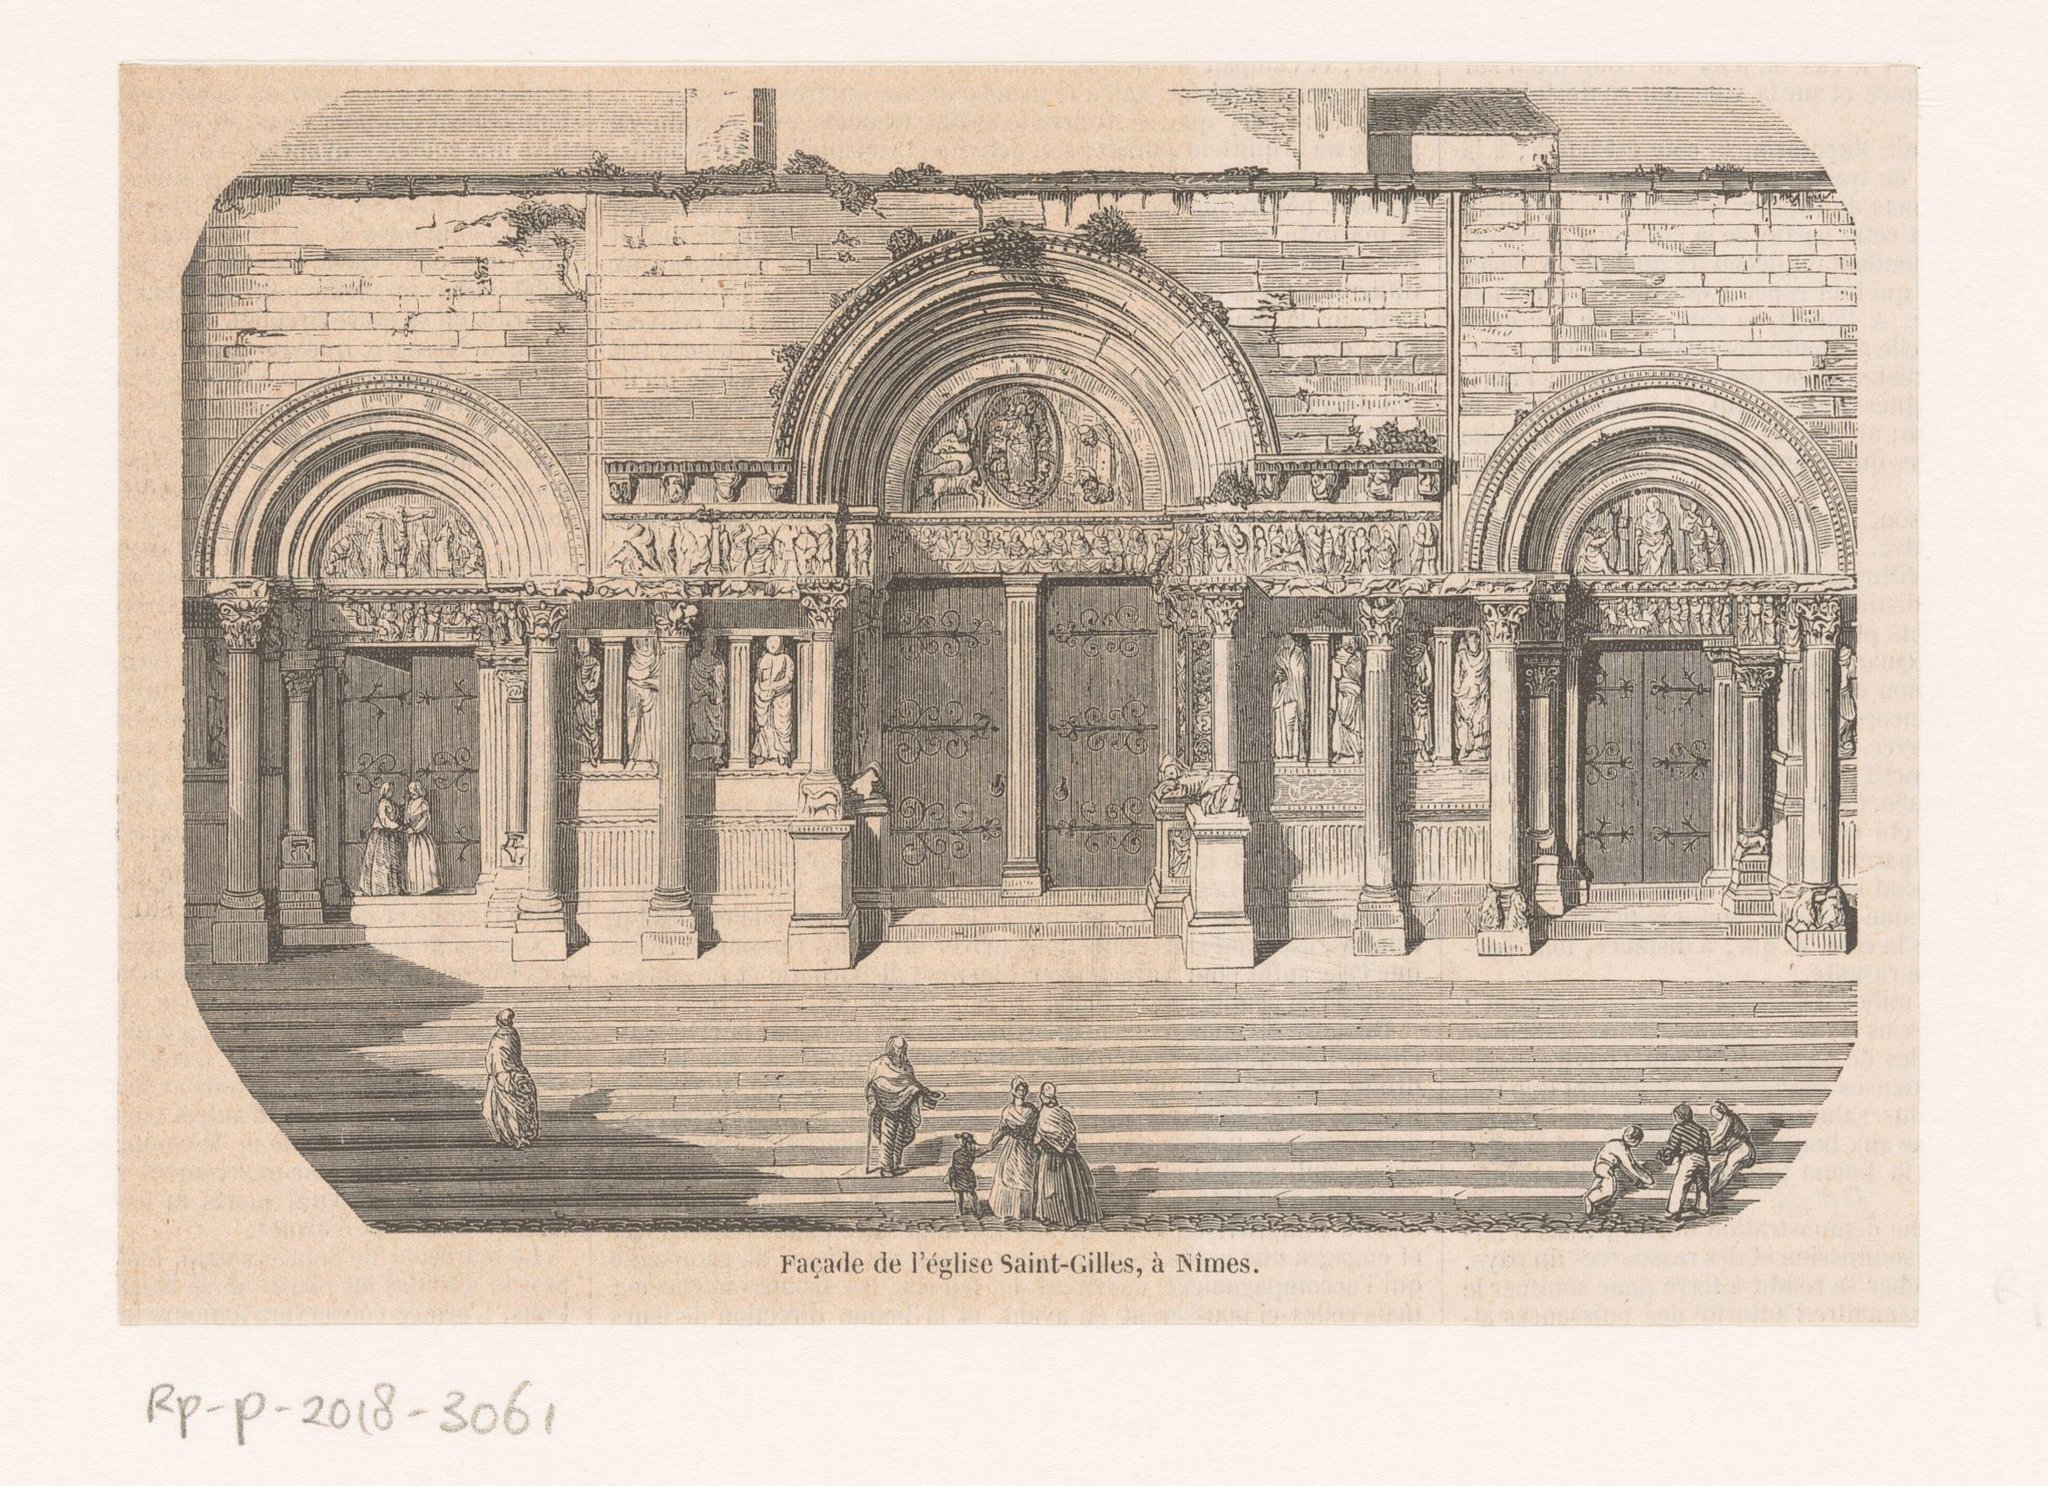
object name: print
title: Façade de l'église Saint-Gilles, a Nîmes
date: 1854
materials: paper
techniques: letterpress printing, engraving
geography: paris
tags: abbey, monastery, convent ~ roman catholic church, roman catholic church, parts of church exterior and annexes: façade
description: Prent uit: L'Illustration, vol. 24, nr. 611, 11 november 1854, p. 332.